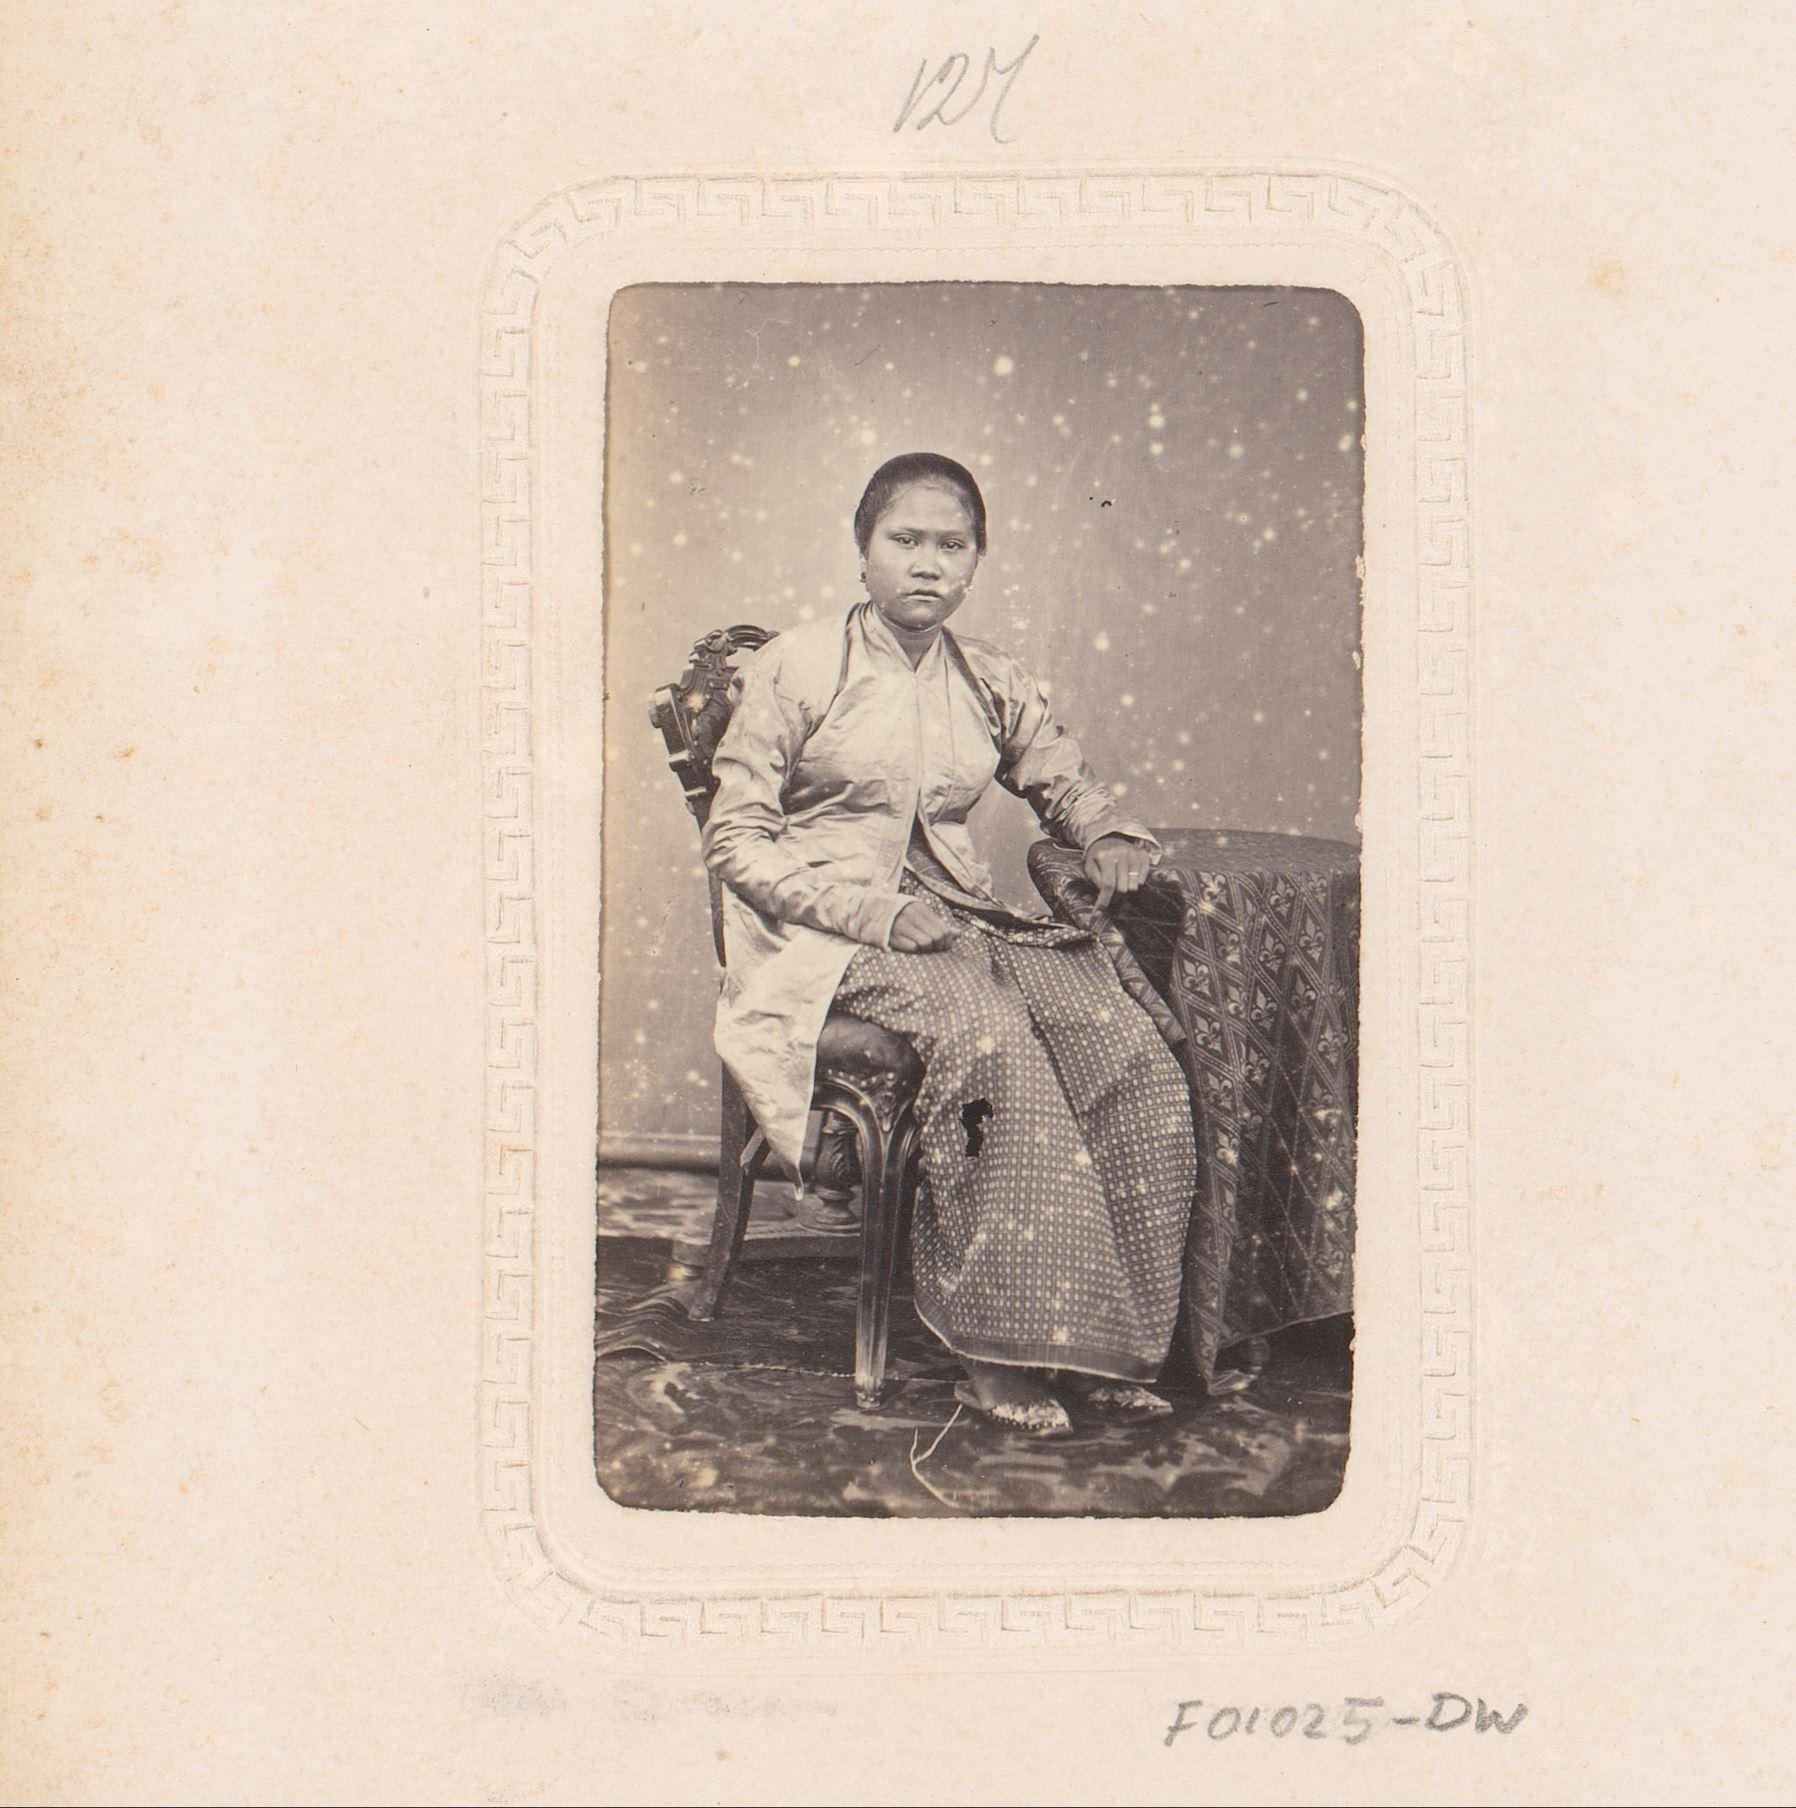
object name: album leaf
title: Portret van een jonge, zittende Indonesische vrouw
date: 1857-1880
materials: cardboard, photographic support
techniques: albumen print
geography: java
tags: sitting figure, historical persons - bb - woman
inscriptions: number: ‘127’, inscription: ‘Woodbury & Page/ Photographers/ Java’